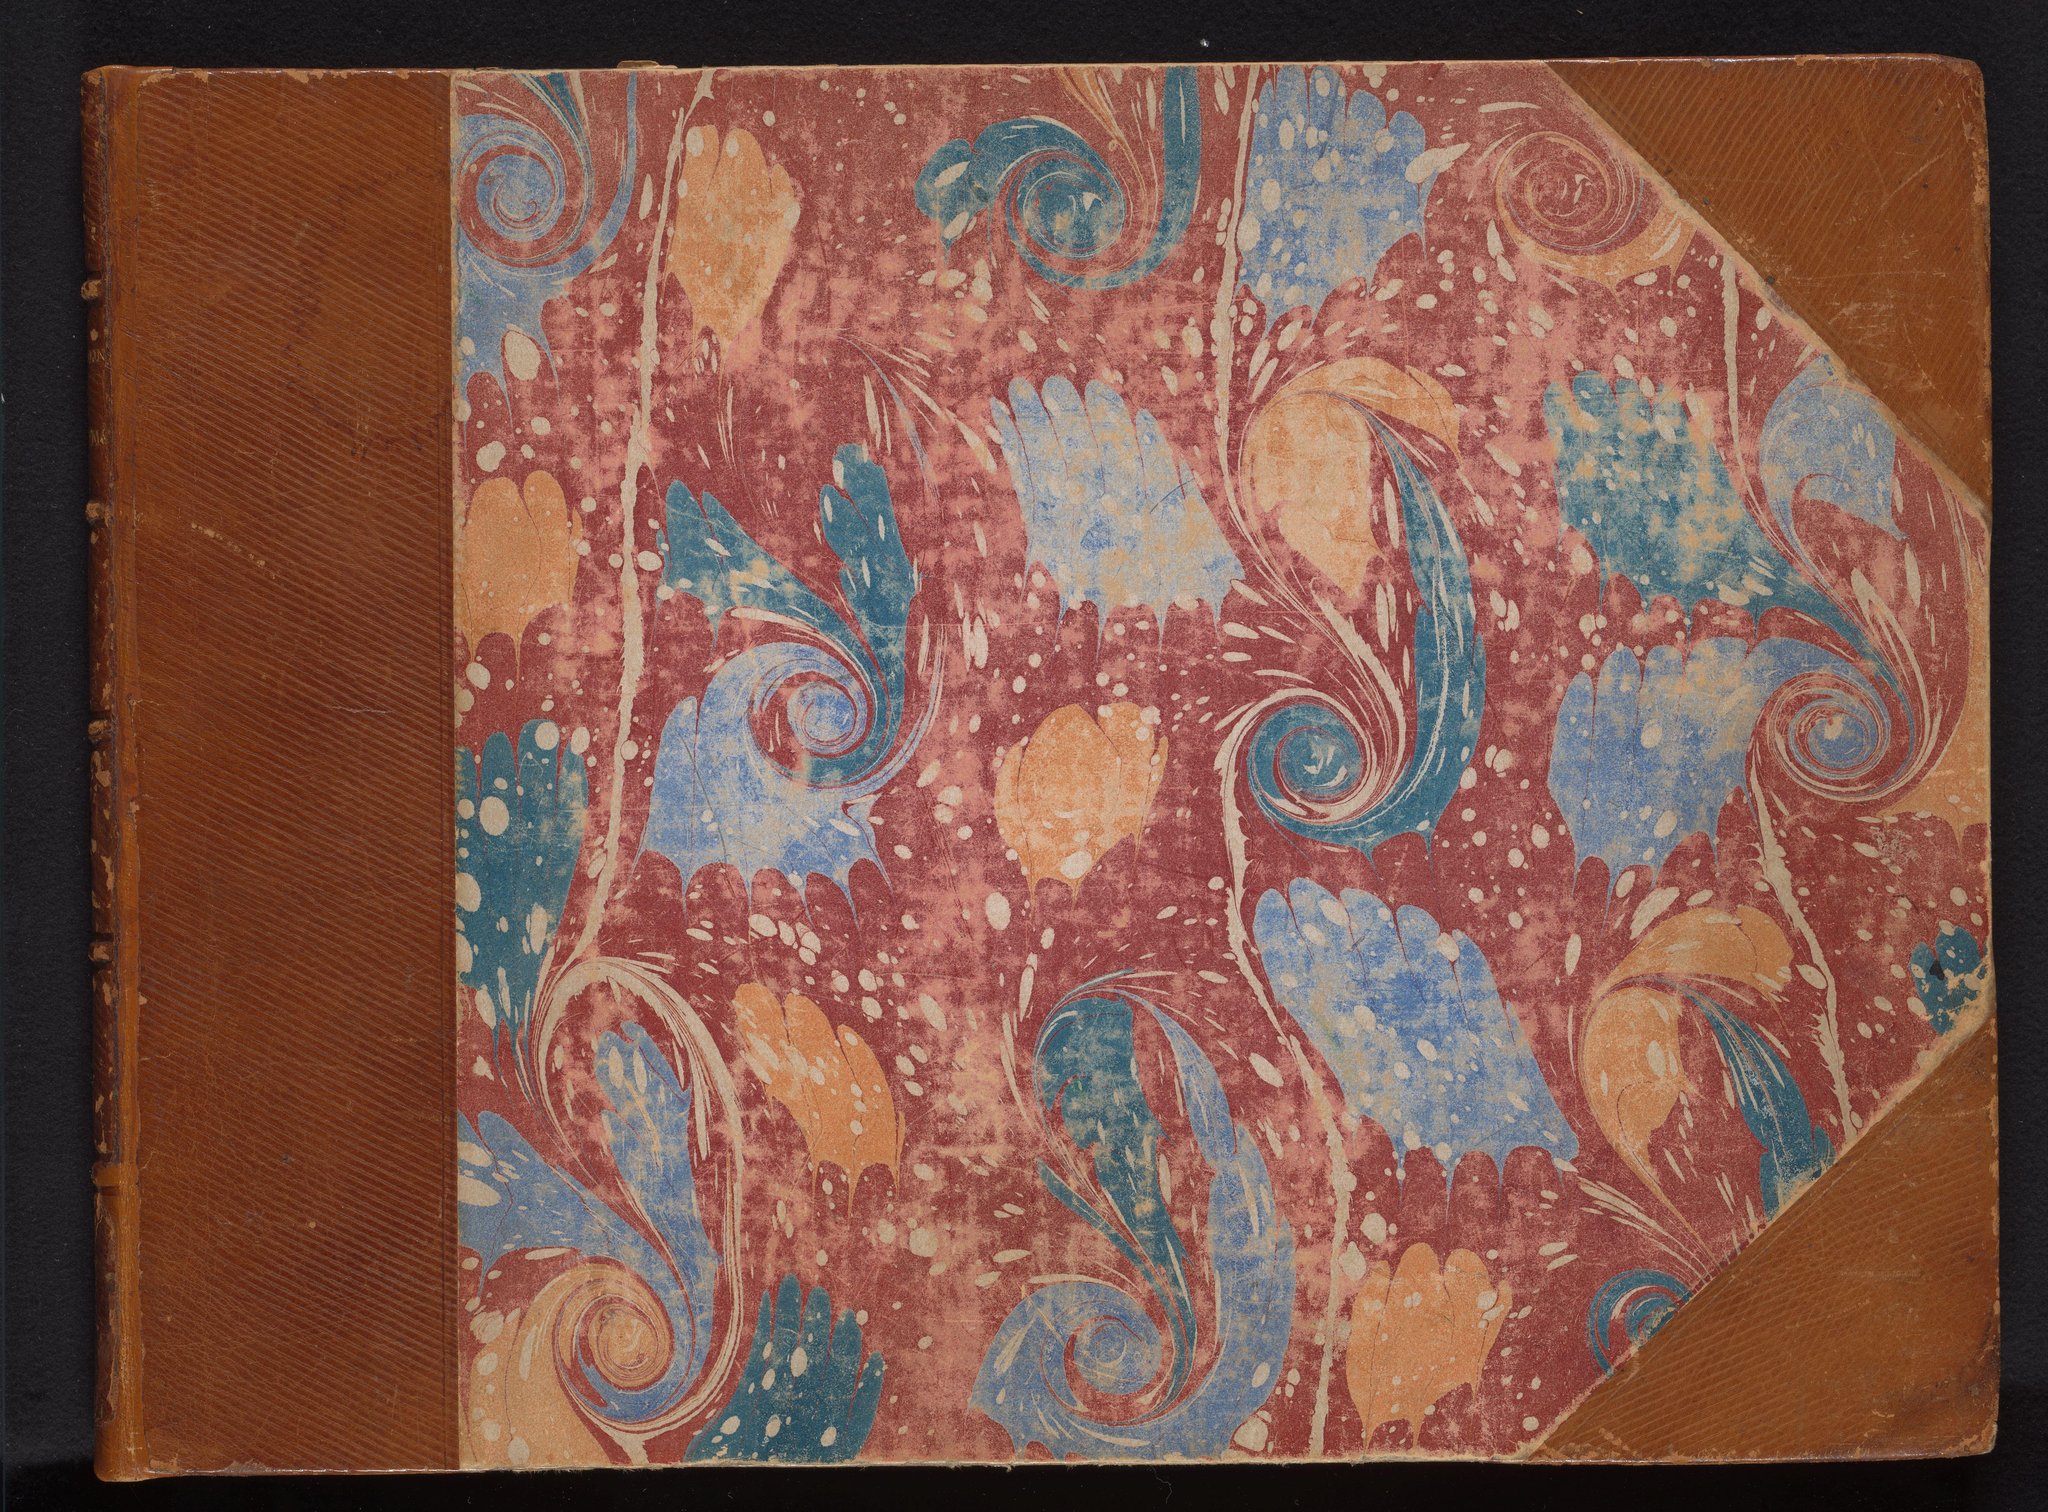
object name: prentrecueil, prentenalbum, prentalbum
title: Trachtenbuch: der Furnembsten Nationen und Volcker kleydungen beyde Manns und Weybs personen in Europa Asia Africa und America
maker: abraham de bruyn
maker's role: print maker, publisher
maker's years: 1540-1587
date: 1581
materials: paper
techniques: engraving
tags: continents represented allegorically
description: Album met 58 prenten , 1 zonder, 2-58 met nummer, door A. de Bruyn. In één band met: Exhibemus hoc libello Romani pontificis, episcoporum, monachorum, aliorumque sacerdotum... imagines ... Antverpiae 3 Augusti, 1581.